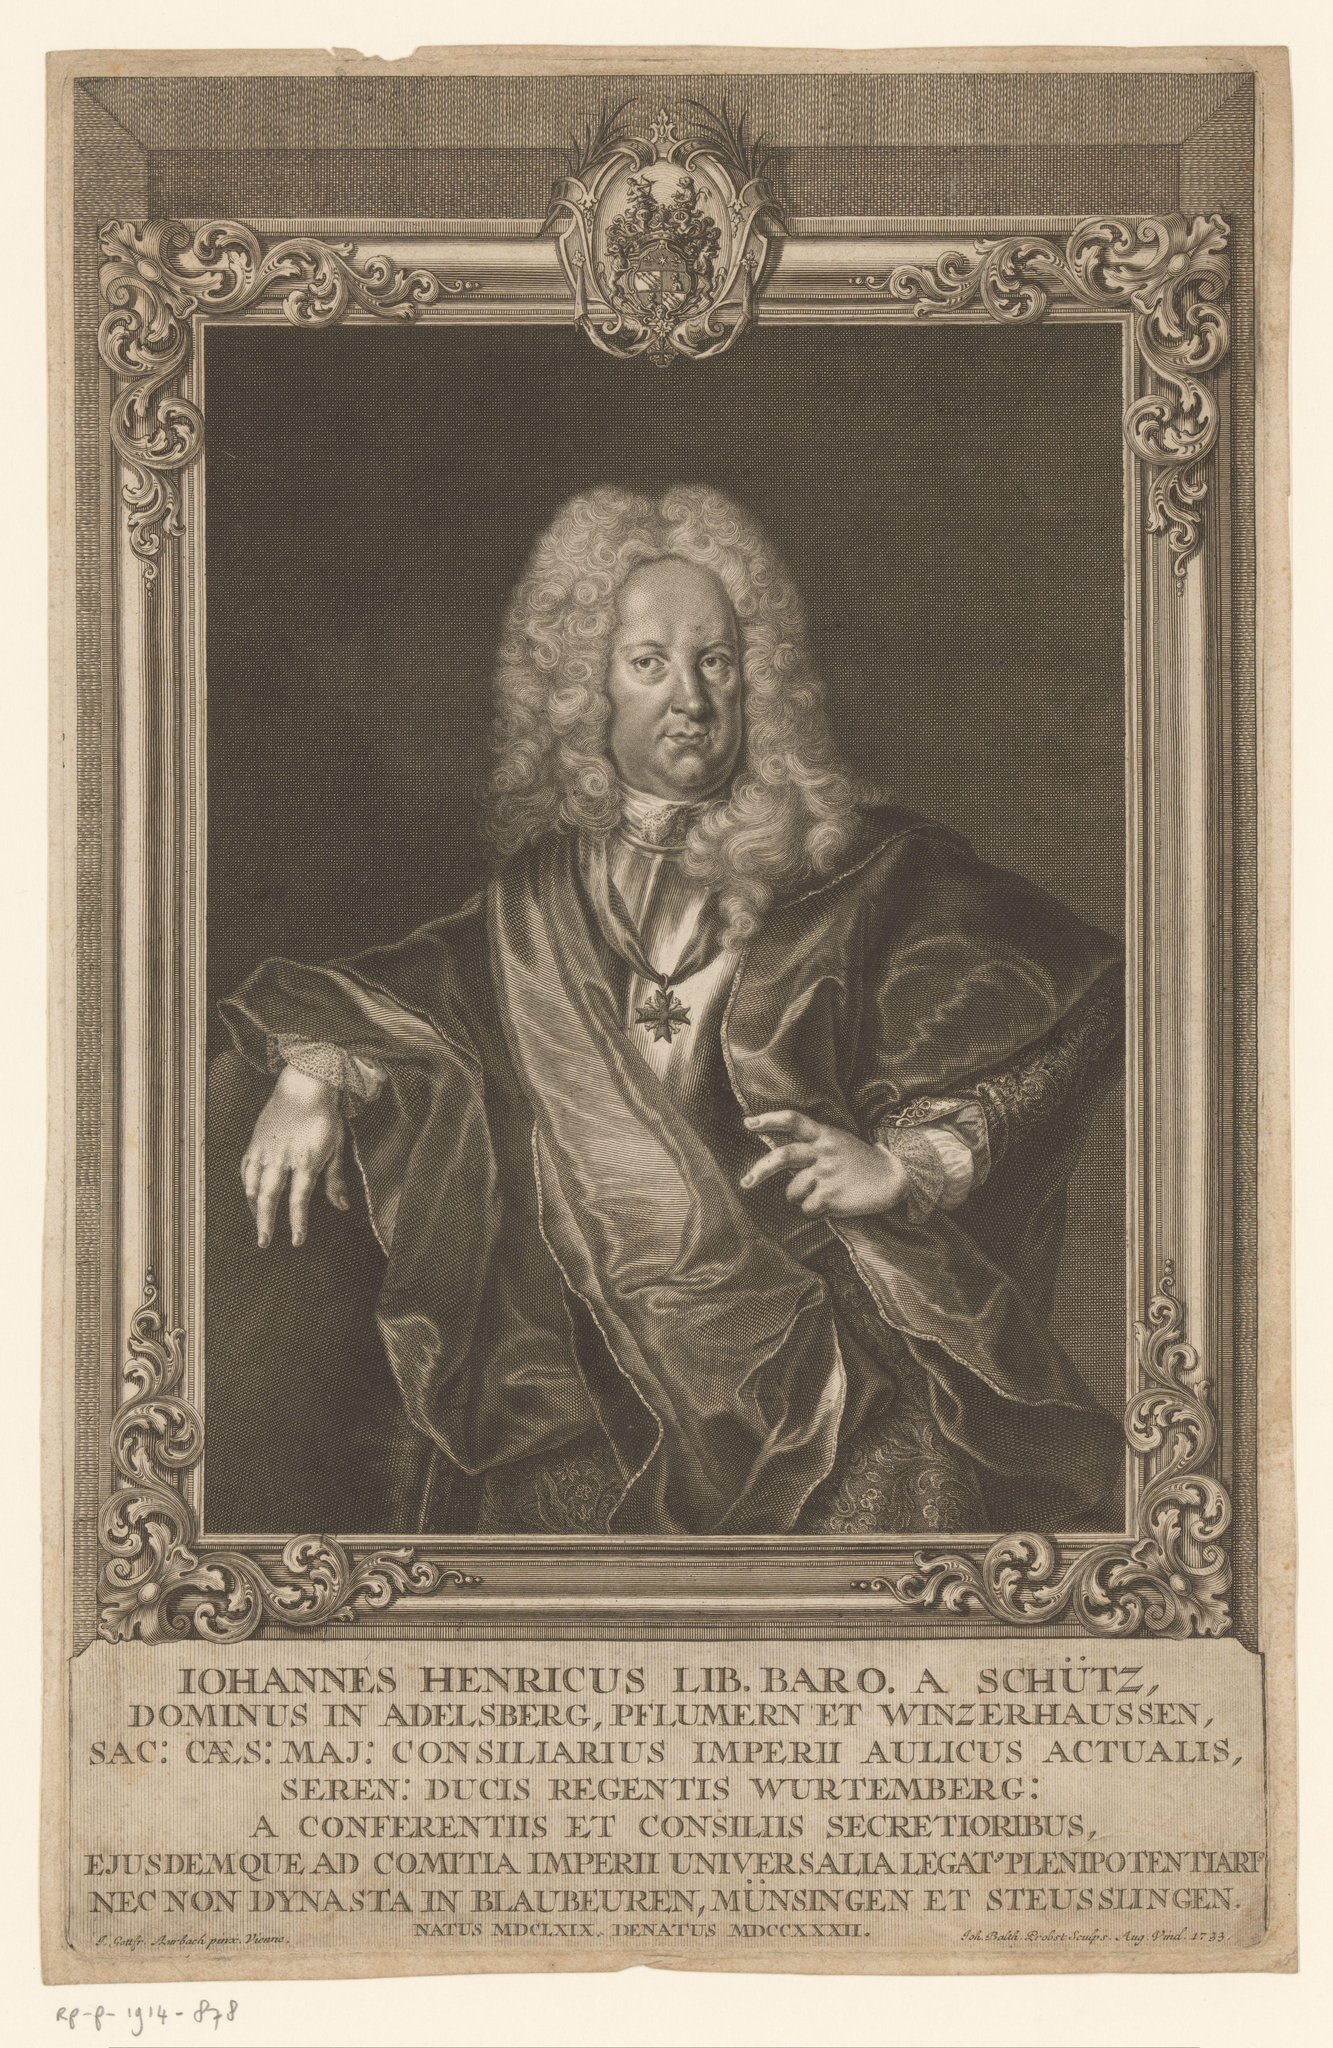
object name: print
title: Portret van Johannes Henricus, baron van Schütz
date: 1683-1750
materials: paper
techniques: engraving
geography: augsburg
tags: historical persons, medals and other marks of military honour, armorial bearing, heraldry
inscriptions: collector's mark: Lugt 2228